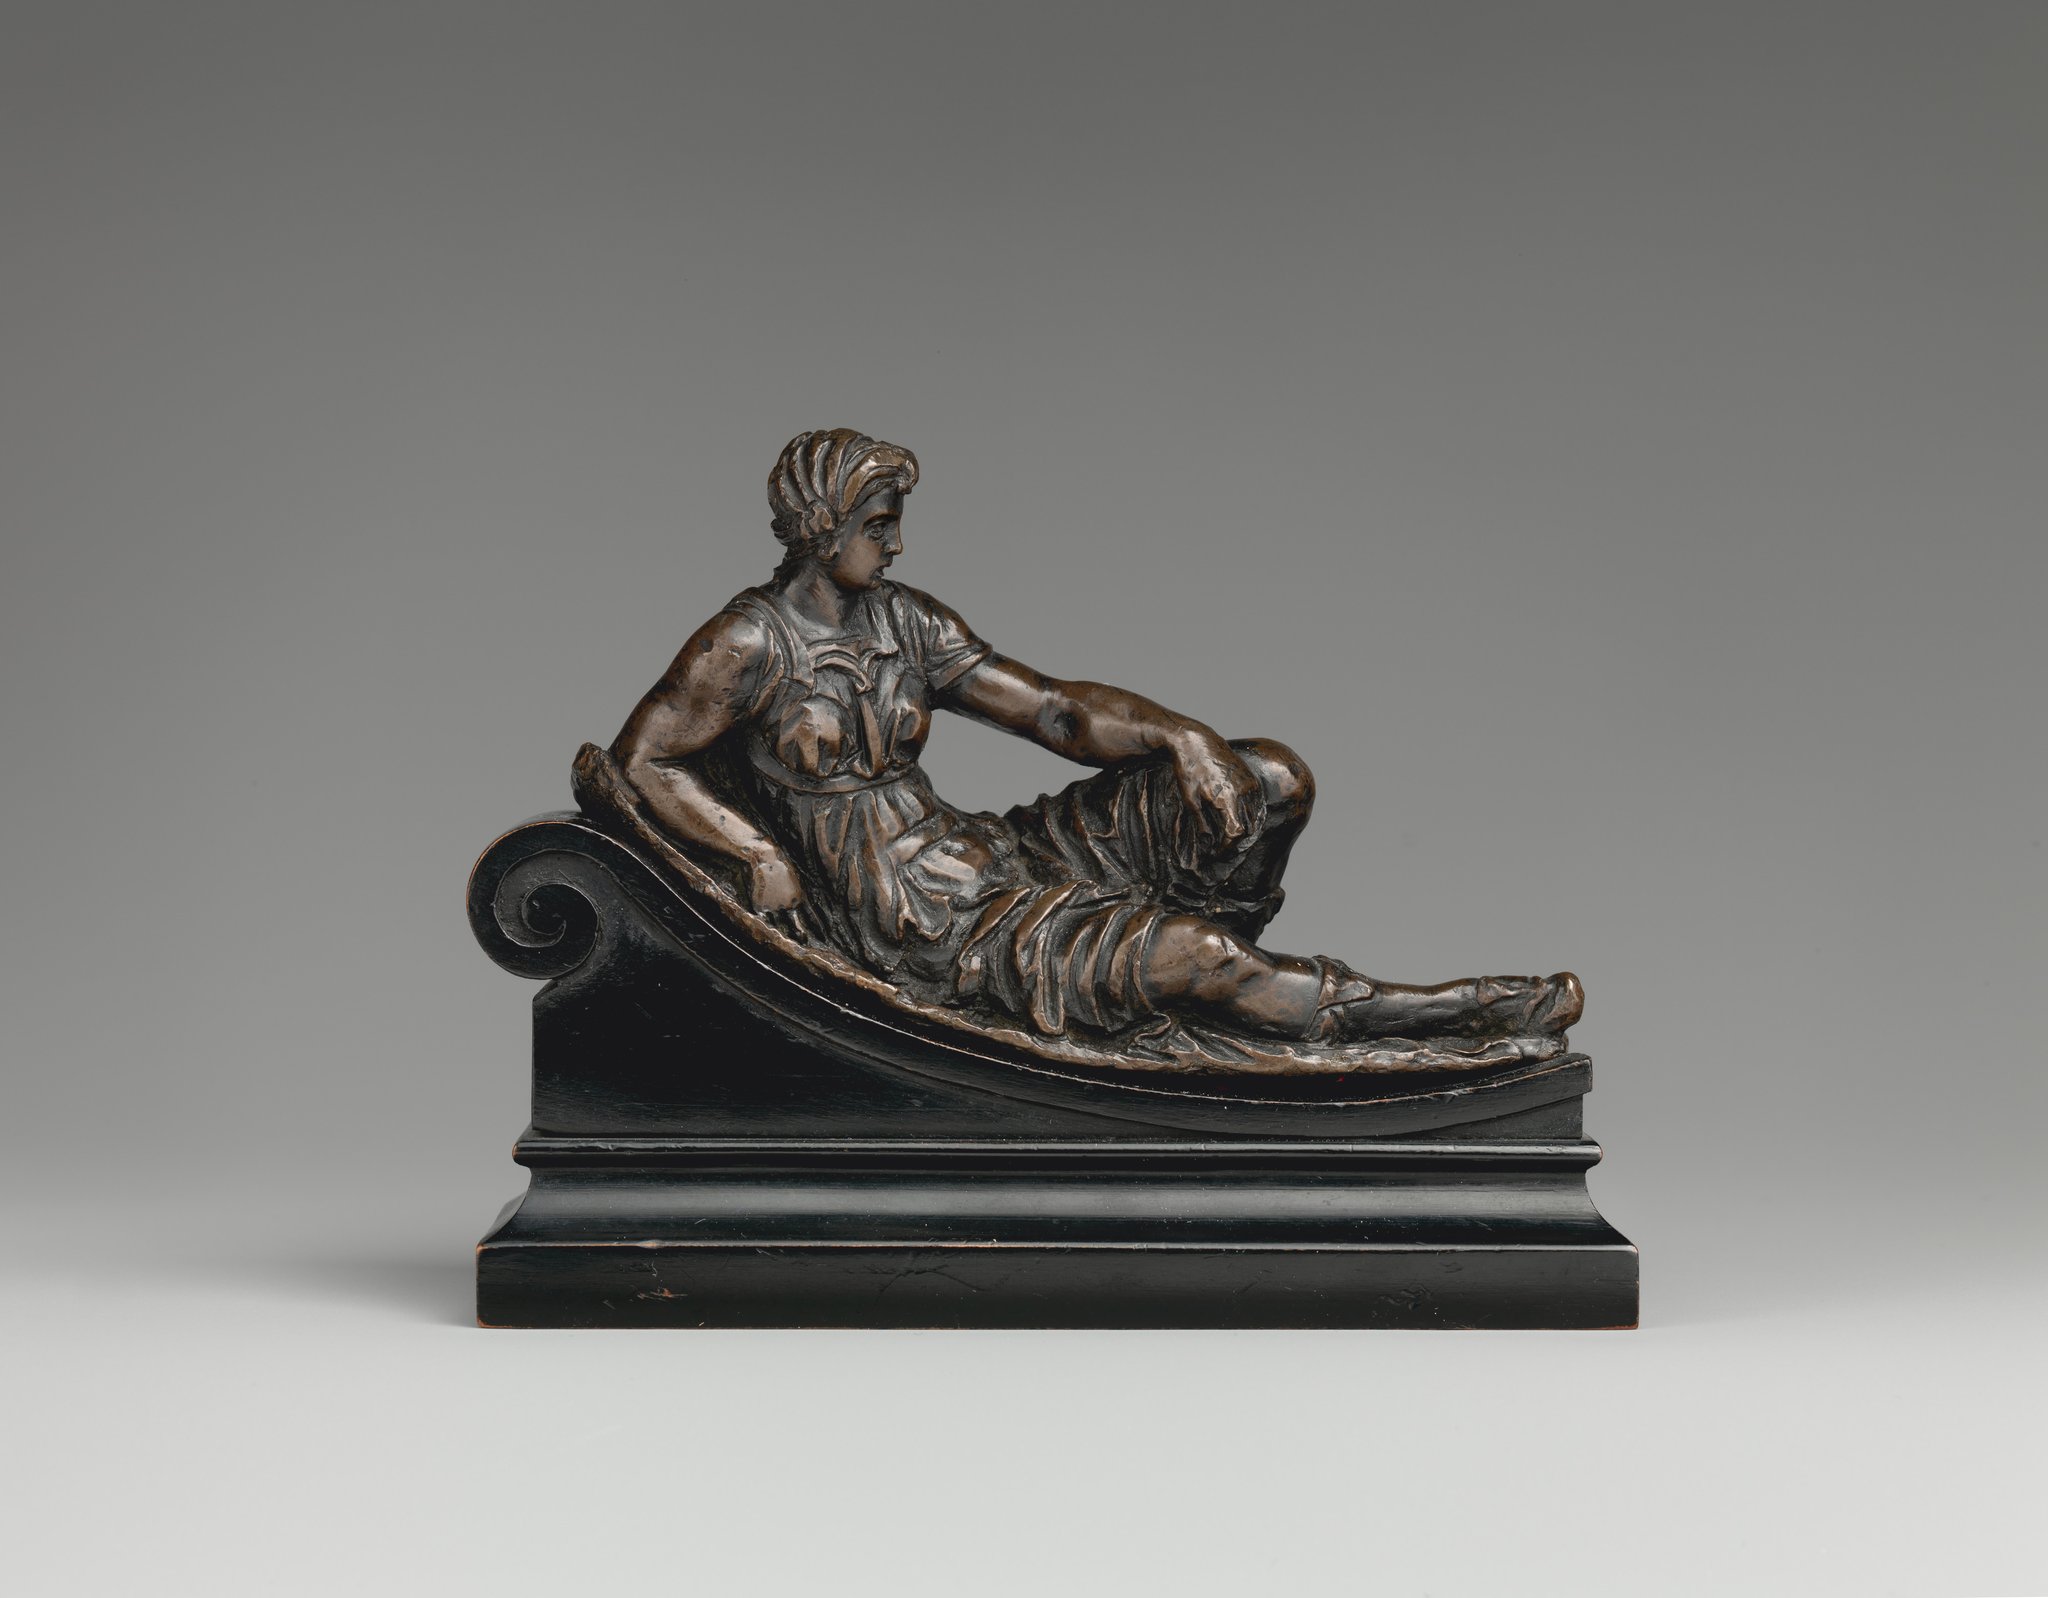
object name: statuette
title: Reclining female figure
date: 1534-1566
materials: bronze, wood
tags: women